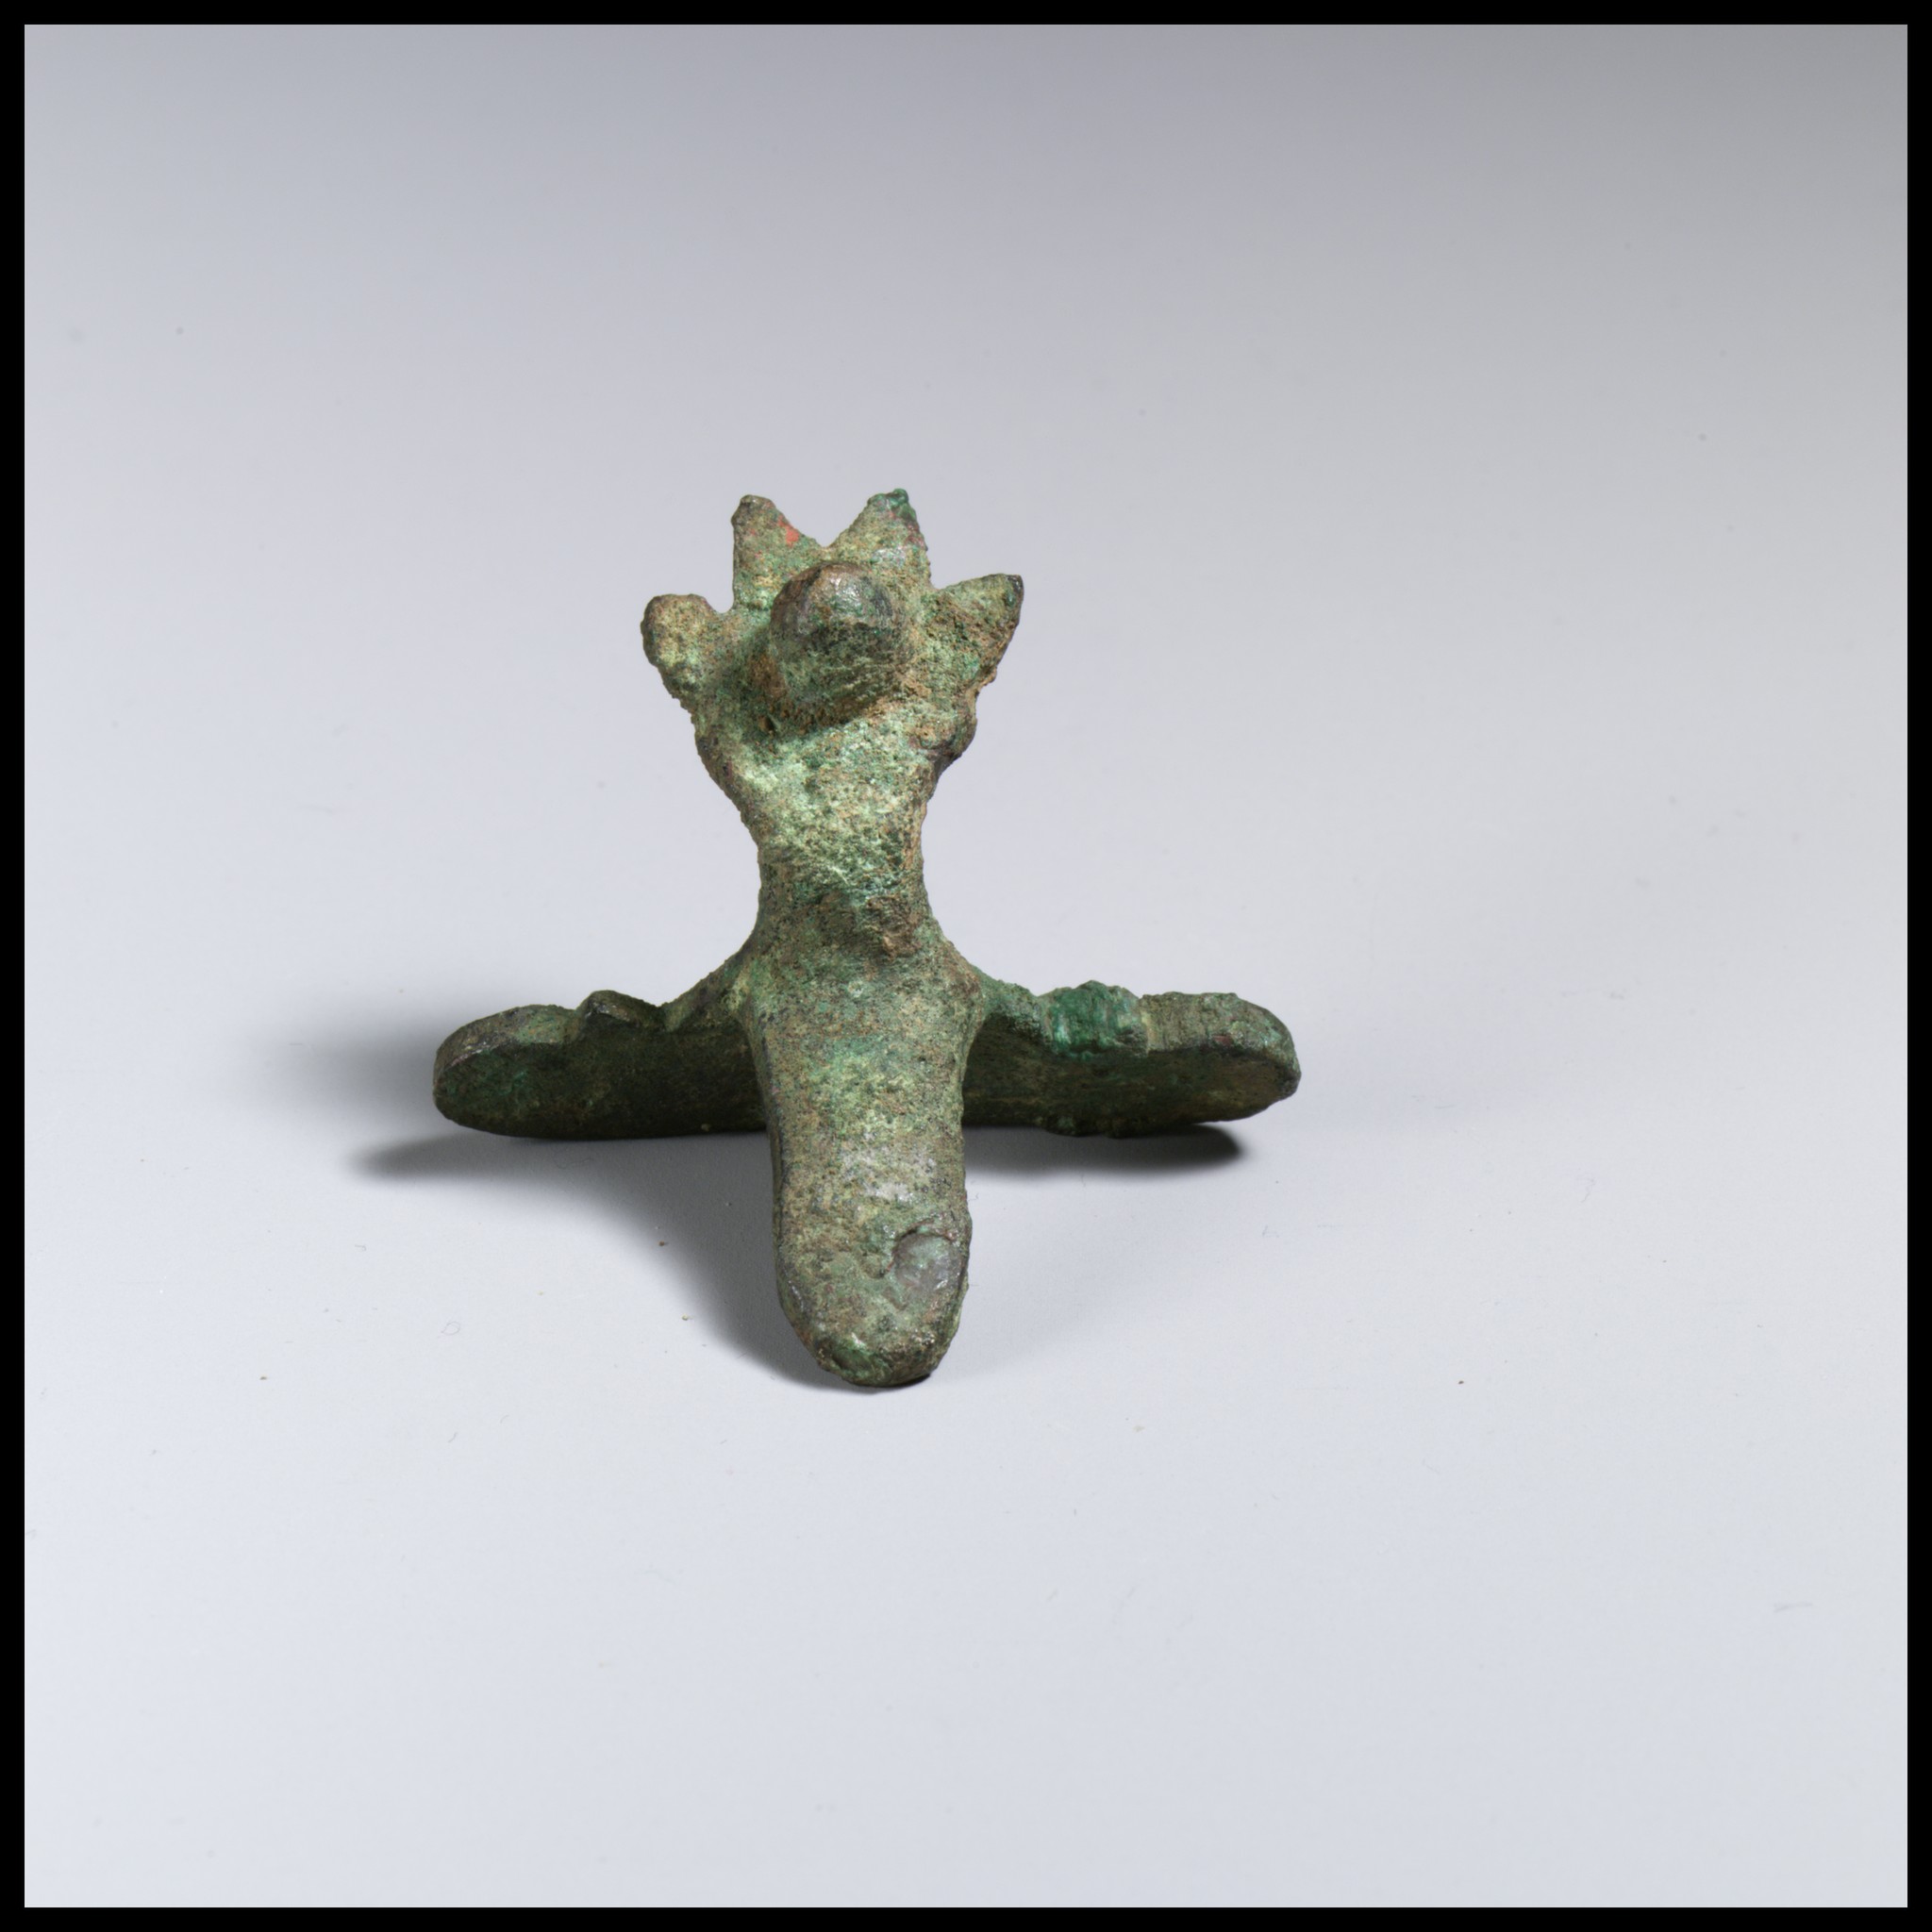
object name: cista, foot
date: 7000 BCE-330 CE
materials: bronze